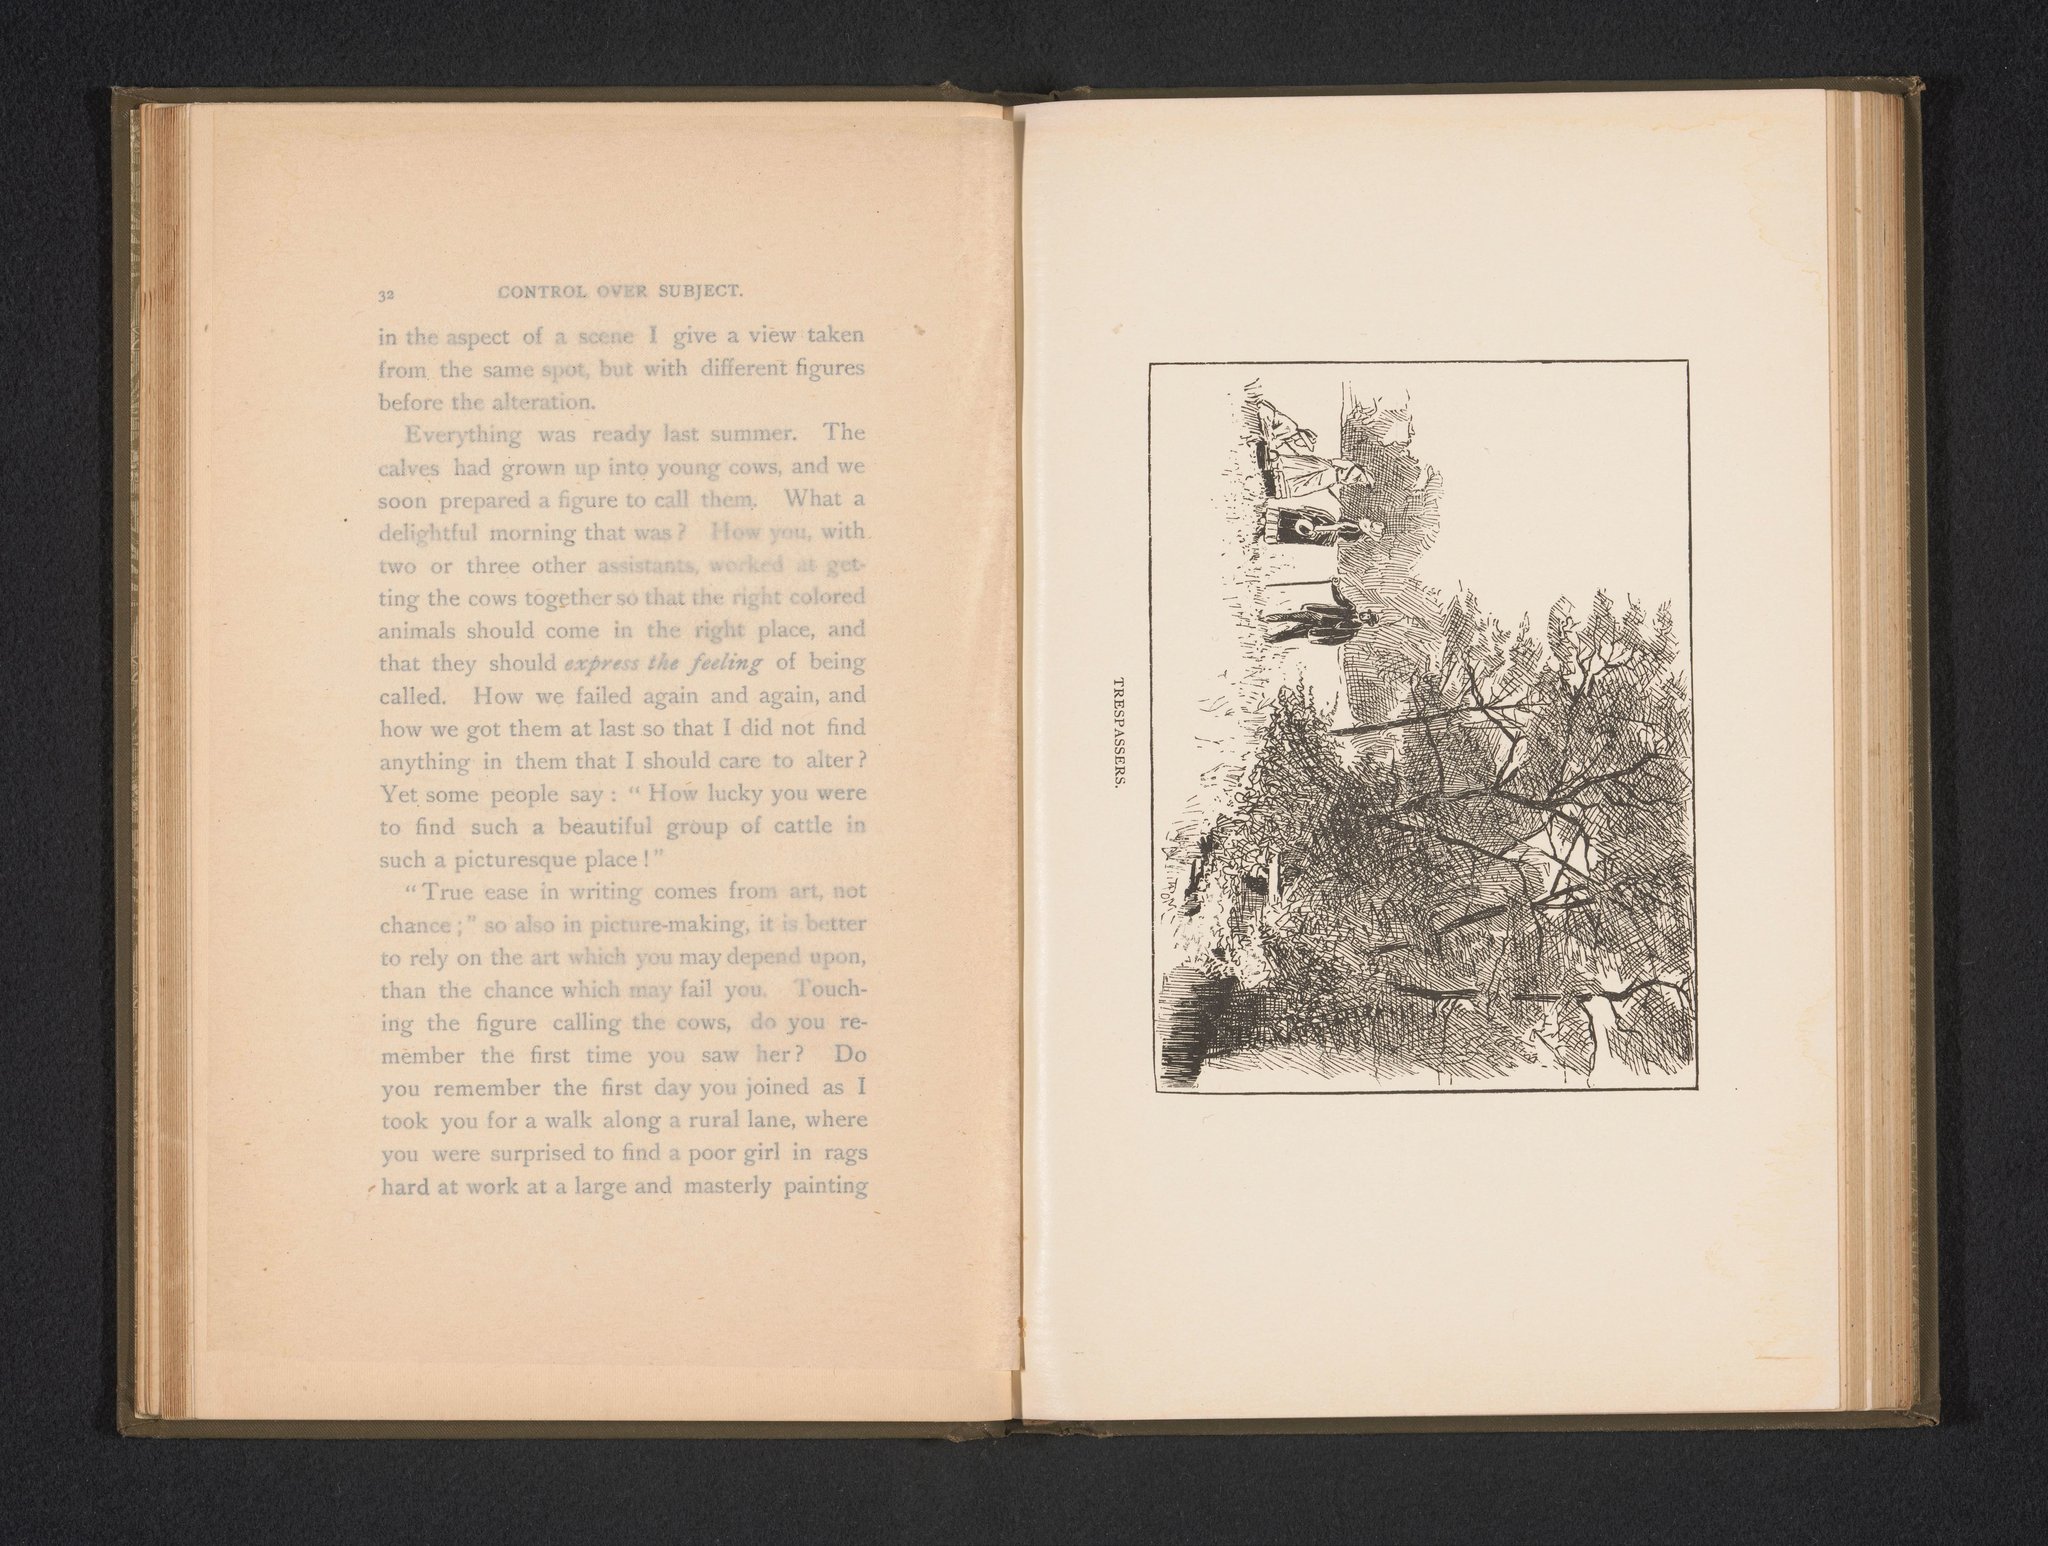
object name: photomechanical print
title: Trespassers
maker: Anonymous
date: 1883-1888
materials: paper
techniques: autotype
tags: landscapes, historical persons (portraits and scenes from the life)